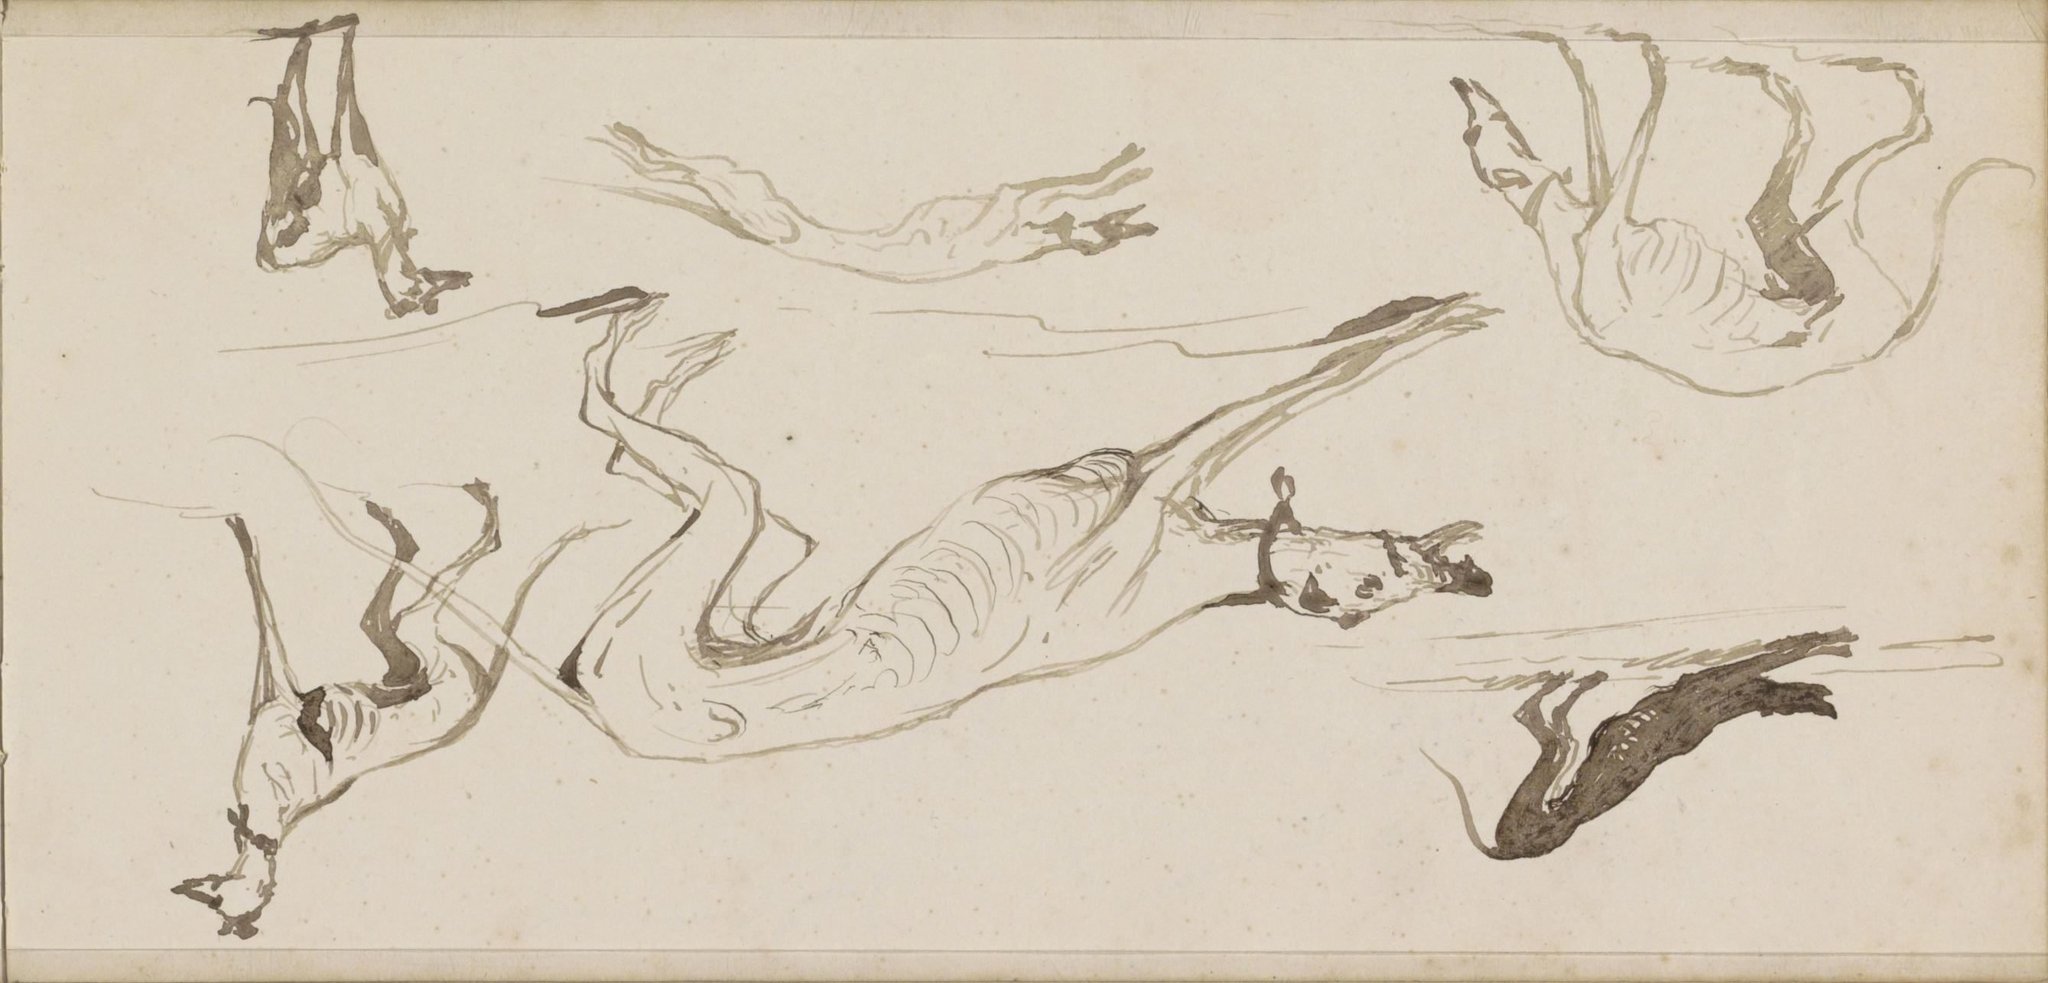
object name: sketchbook leaf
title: Honden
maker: johannes tavenraat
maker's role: draughtsman, painter, print maker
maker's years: 1809-1881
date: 1840-1868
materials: ink, paper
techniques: pen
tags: dog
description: Blad 45 recto uit een schetsboek met 63 bladen.